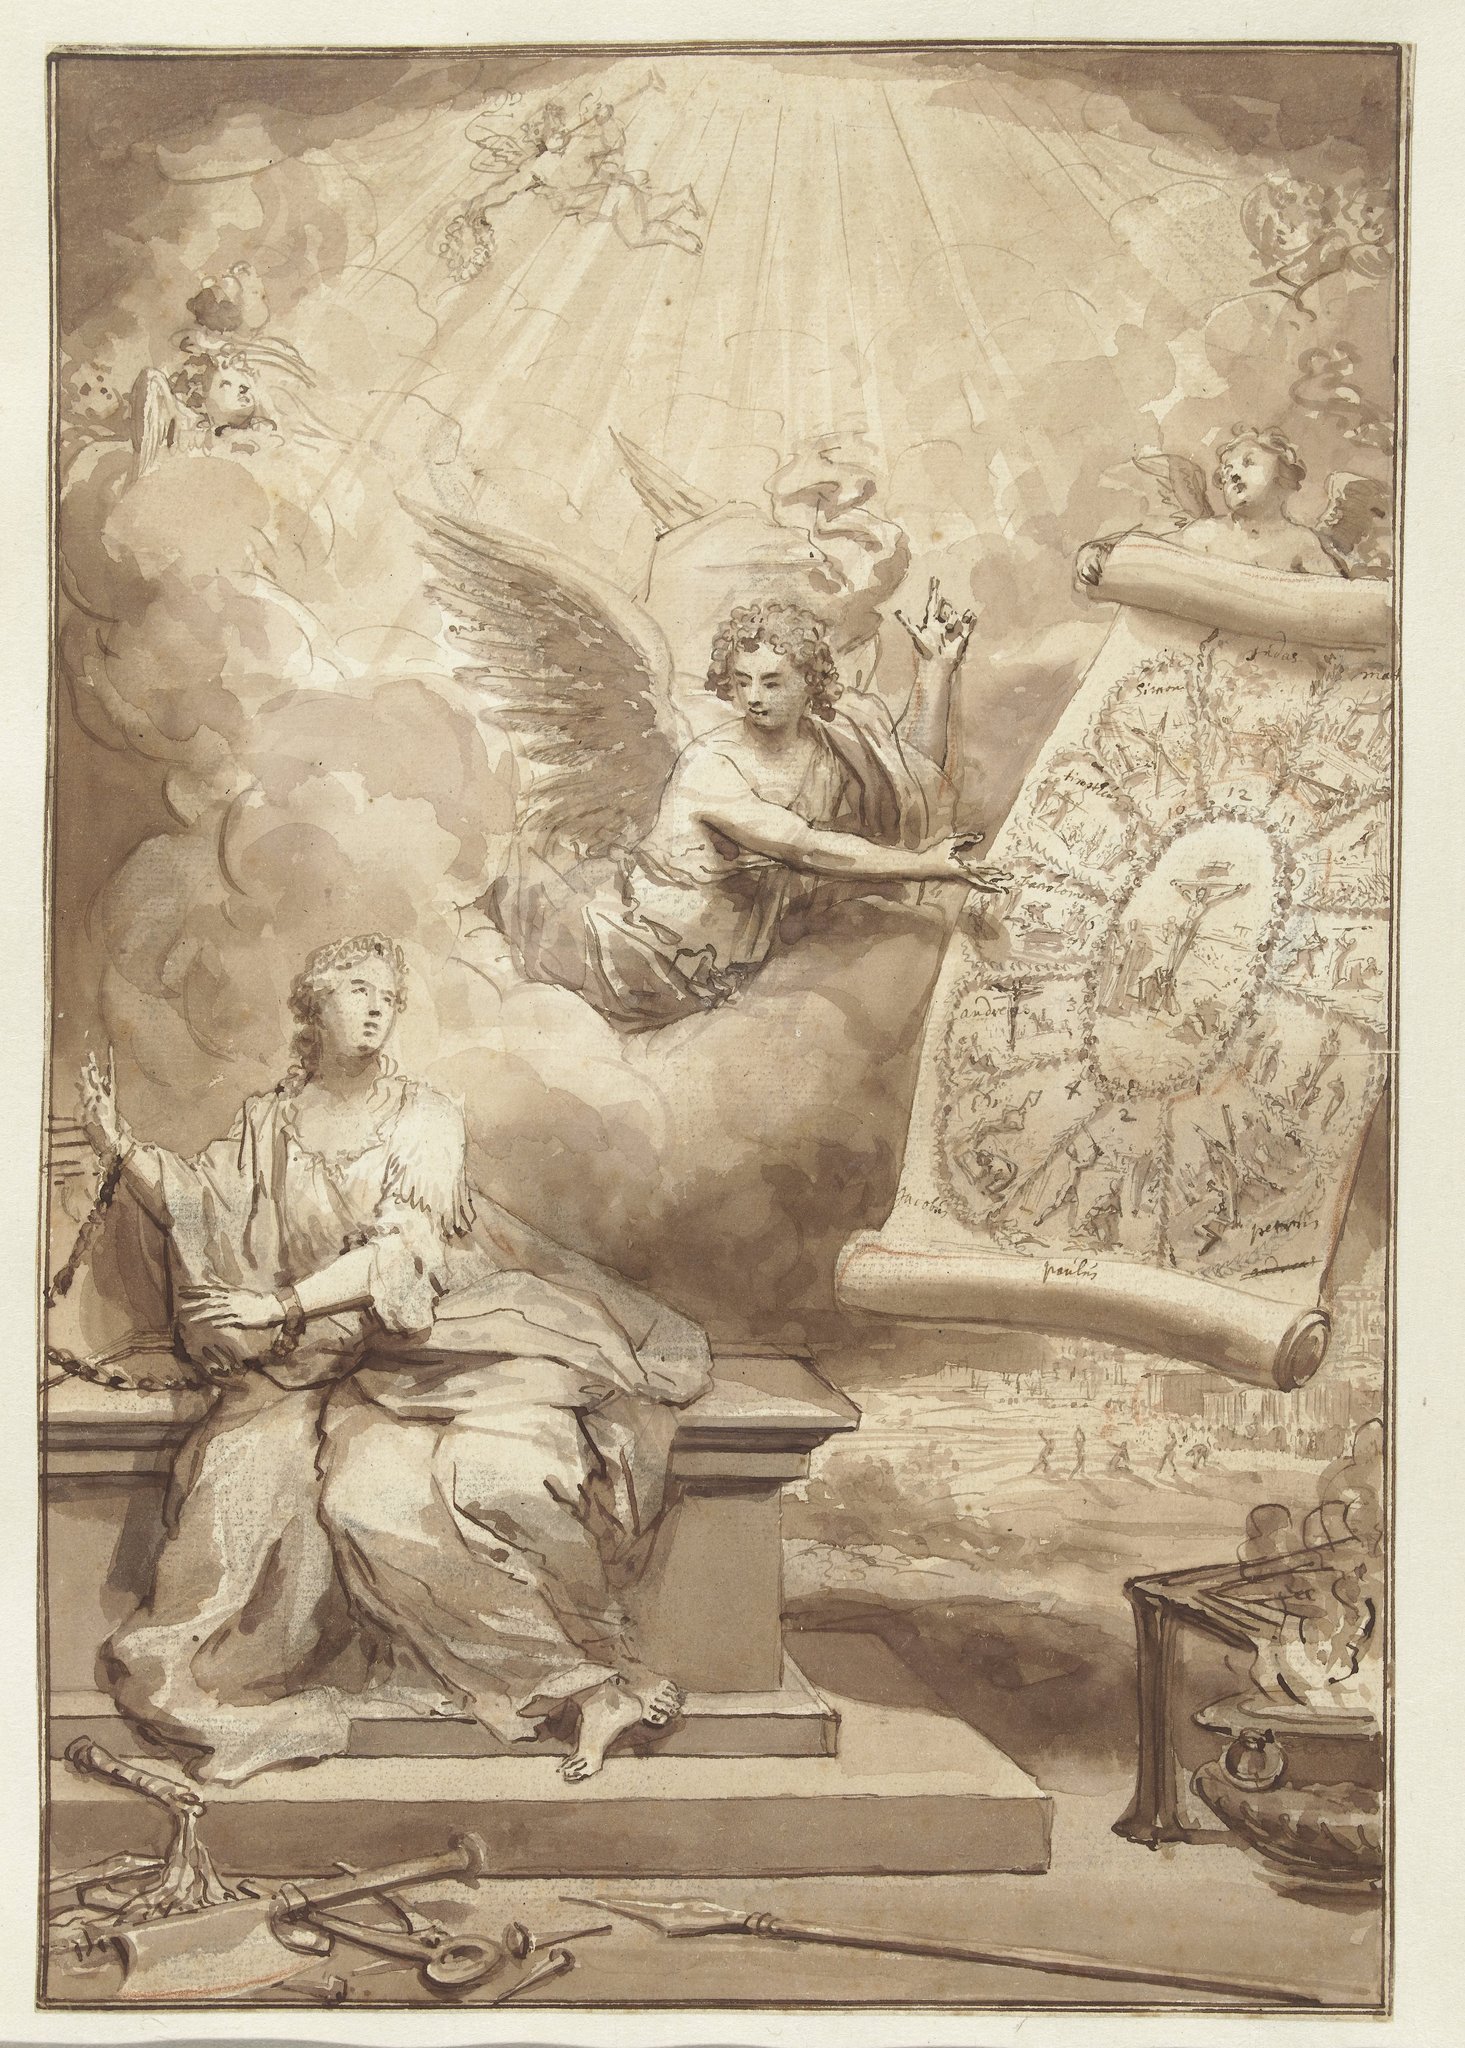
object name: design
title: Frontispiece Design for the New Testament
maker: philip tidemann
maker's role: draughtsman, painter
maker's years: 1657-1705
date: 1700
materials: chalk, graphite, ink, paper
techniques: brush, pen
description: This frontispiece design was for the splendidly illustrated Bible published by Pieter Mortier in Amsterdam in 1700. It is an example of just how inventive and almost surrealistic the illustrations of title pages could be. An angel shows the shackled Church a tableau with scenes of the martyrdom of Christ and his twelve apostles. The instruments of their martyrdom lie in the foreground.